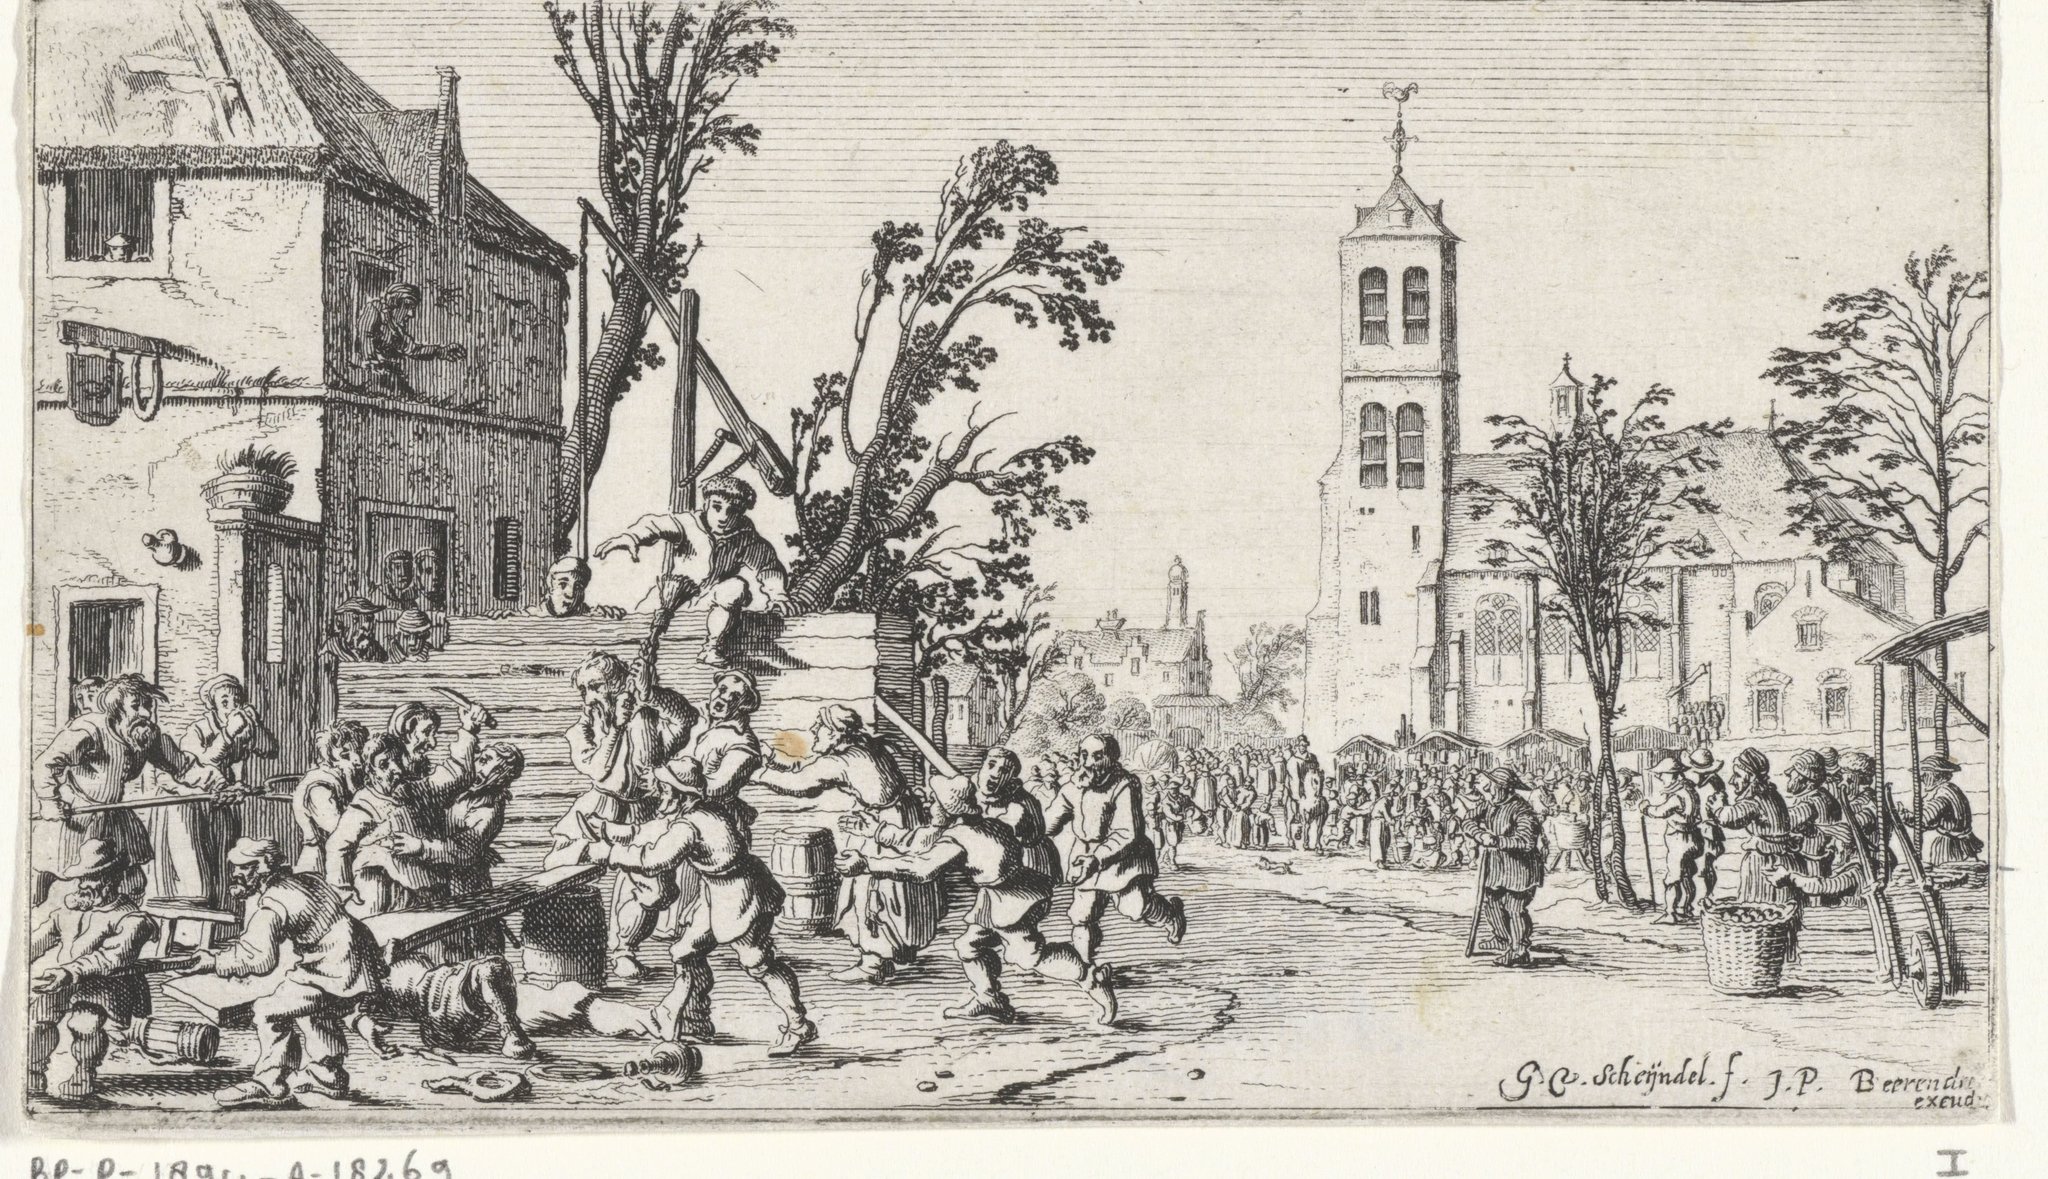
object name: print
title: Gevecht bij een herberg (de Tastzin)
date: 1618-1645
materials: paper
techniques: etching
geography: haarlem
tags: taste, tasting (one of the five senses), hotel, hostelry, inn, village square, place, fighting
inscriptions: collector's mark: Lugt 2228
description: De Tastzin. Voor een herberg bij een marktplein vindt een gevecht plaats tussen verschillende mannen. Op de achtergrond het marktplein en een kerk. De prent maakt deel uit van een serie van landschappen met de vijf zintuigen.